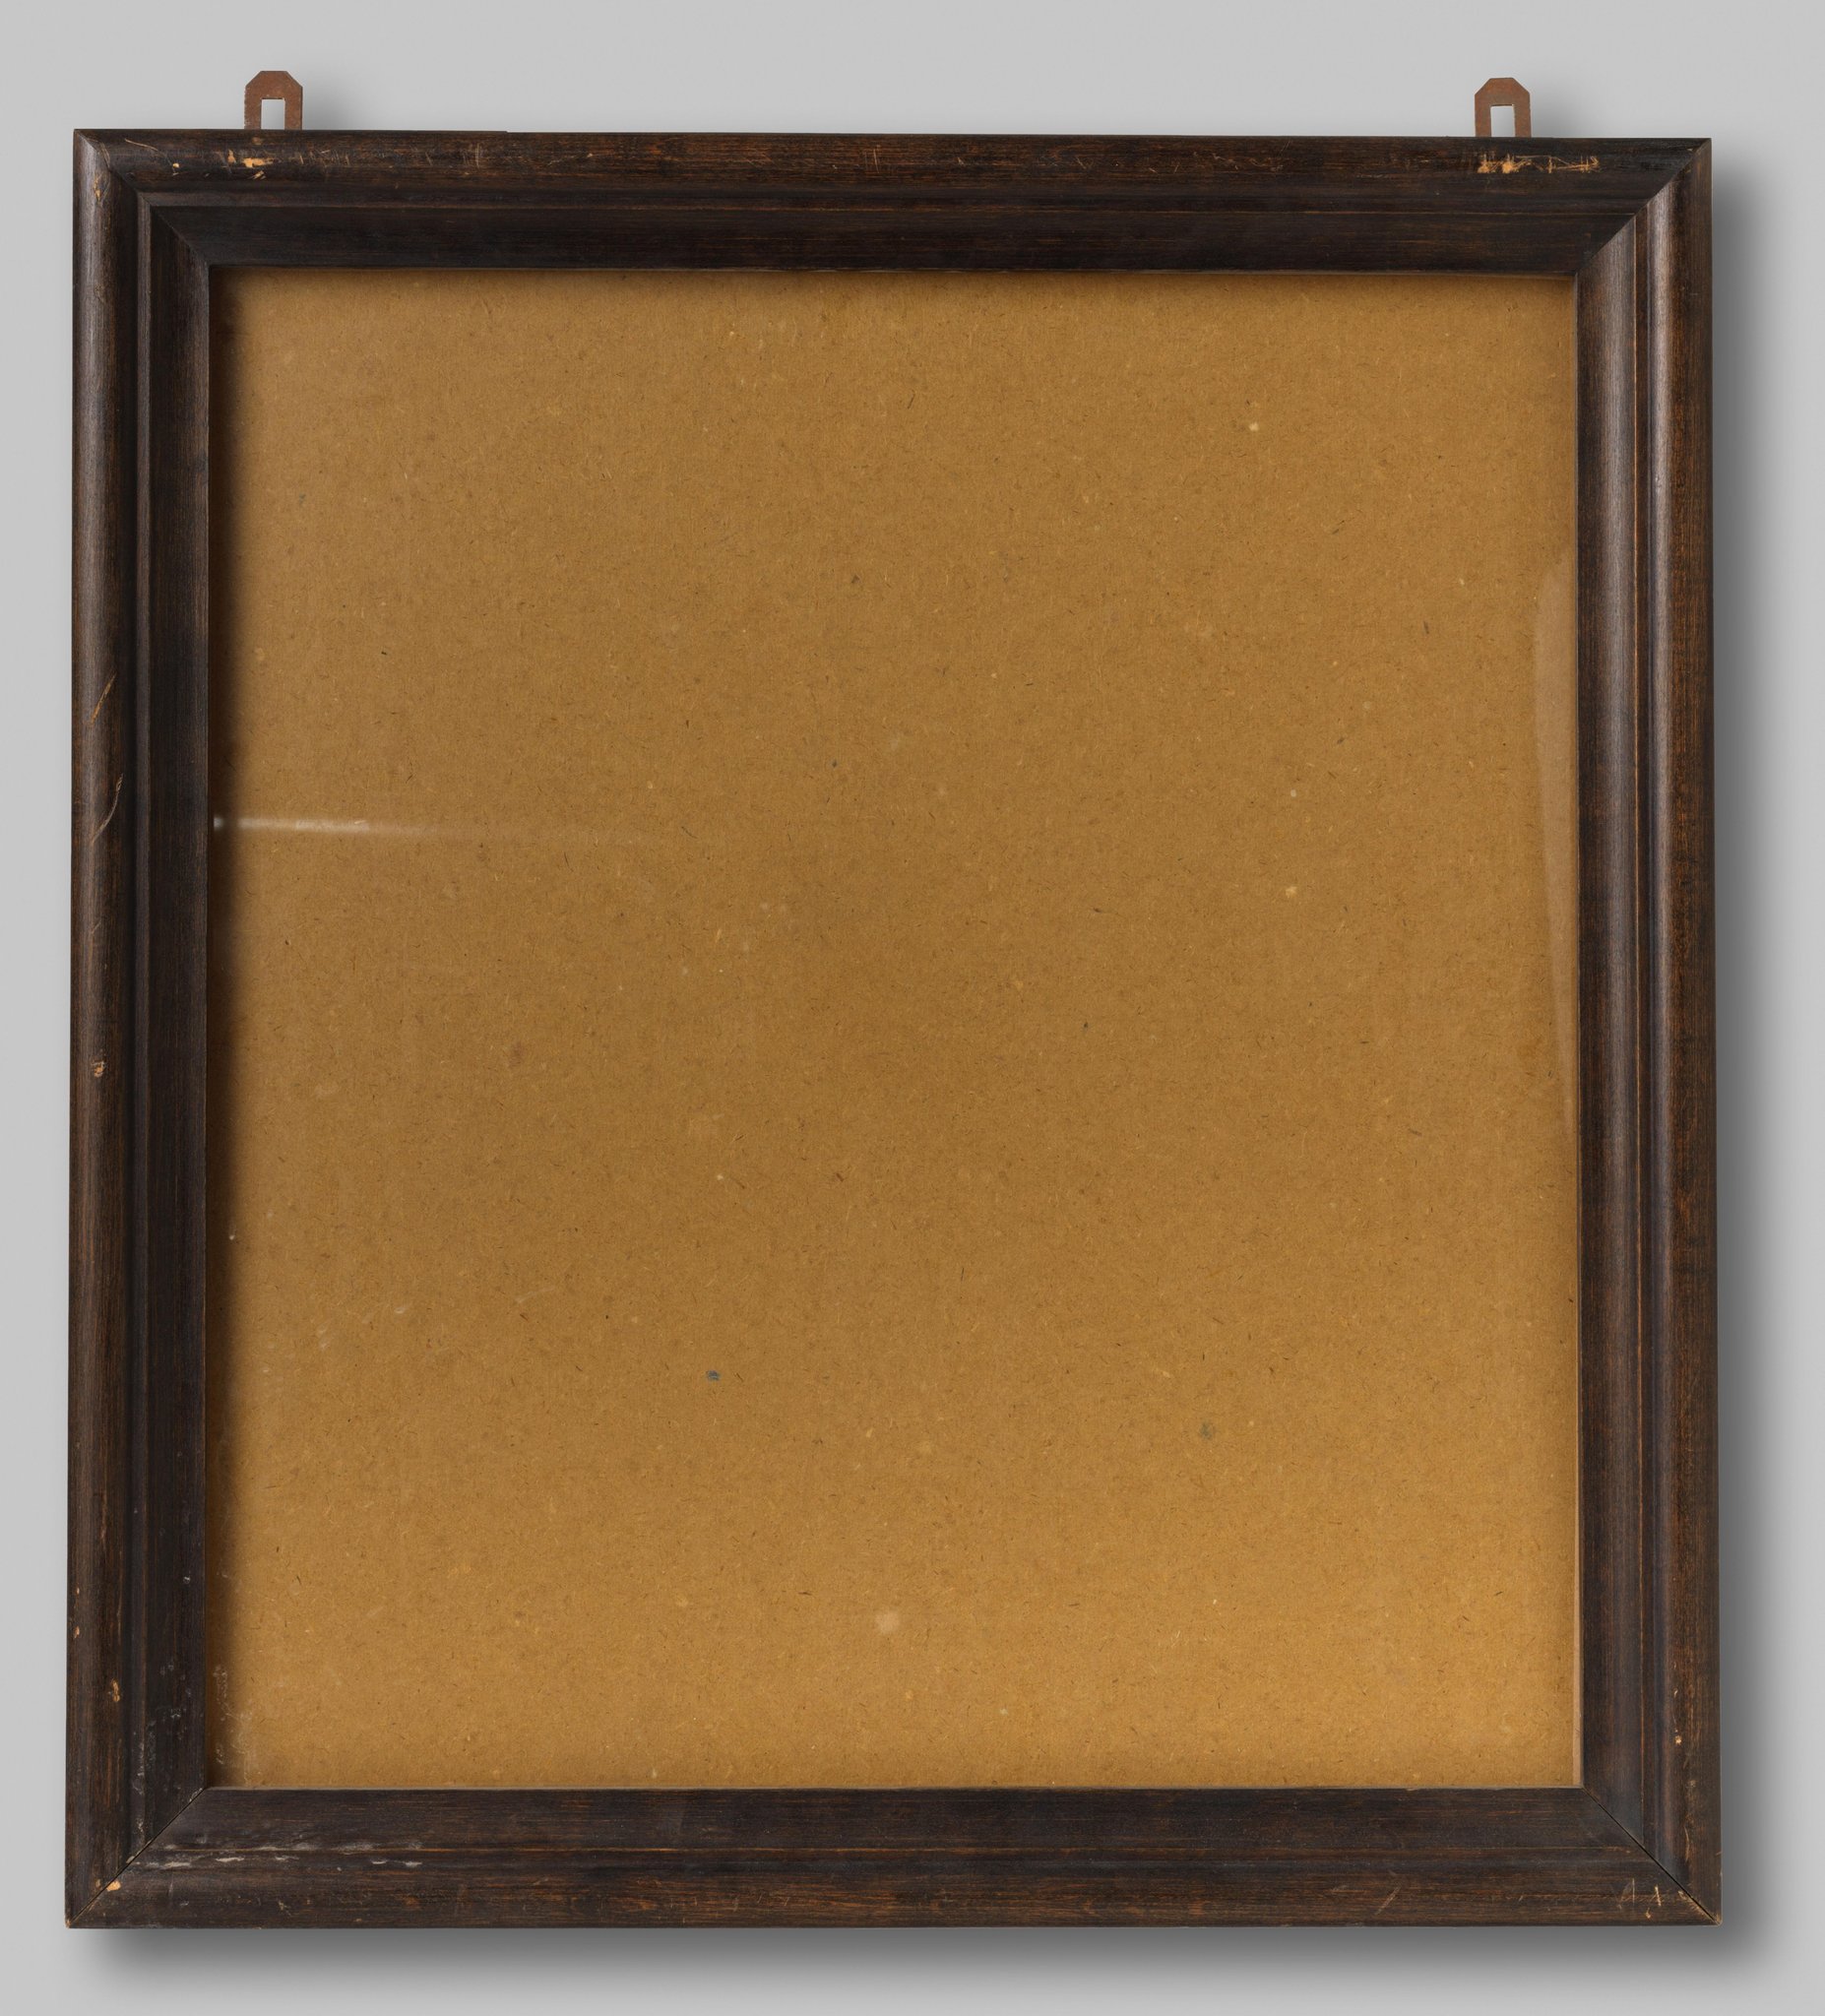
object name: frame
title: Lijst van hout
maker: Anonymous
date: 1900-1979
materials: metal, wood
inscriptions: label: ‘Bewaarneming mevrouw Mees-Verwey / Santpoort, 1950’, : ‘RH.17’